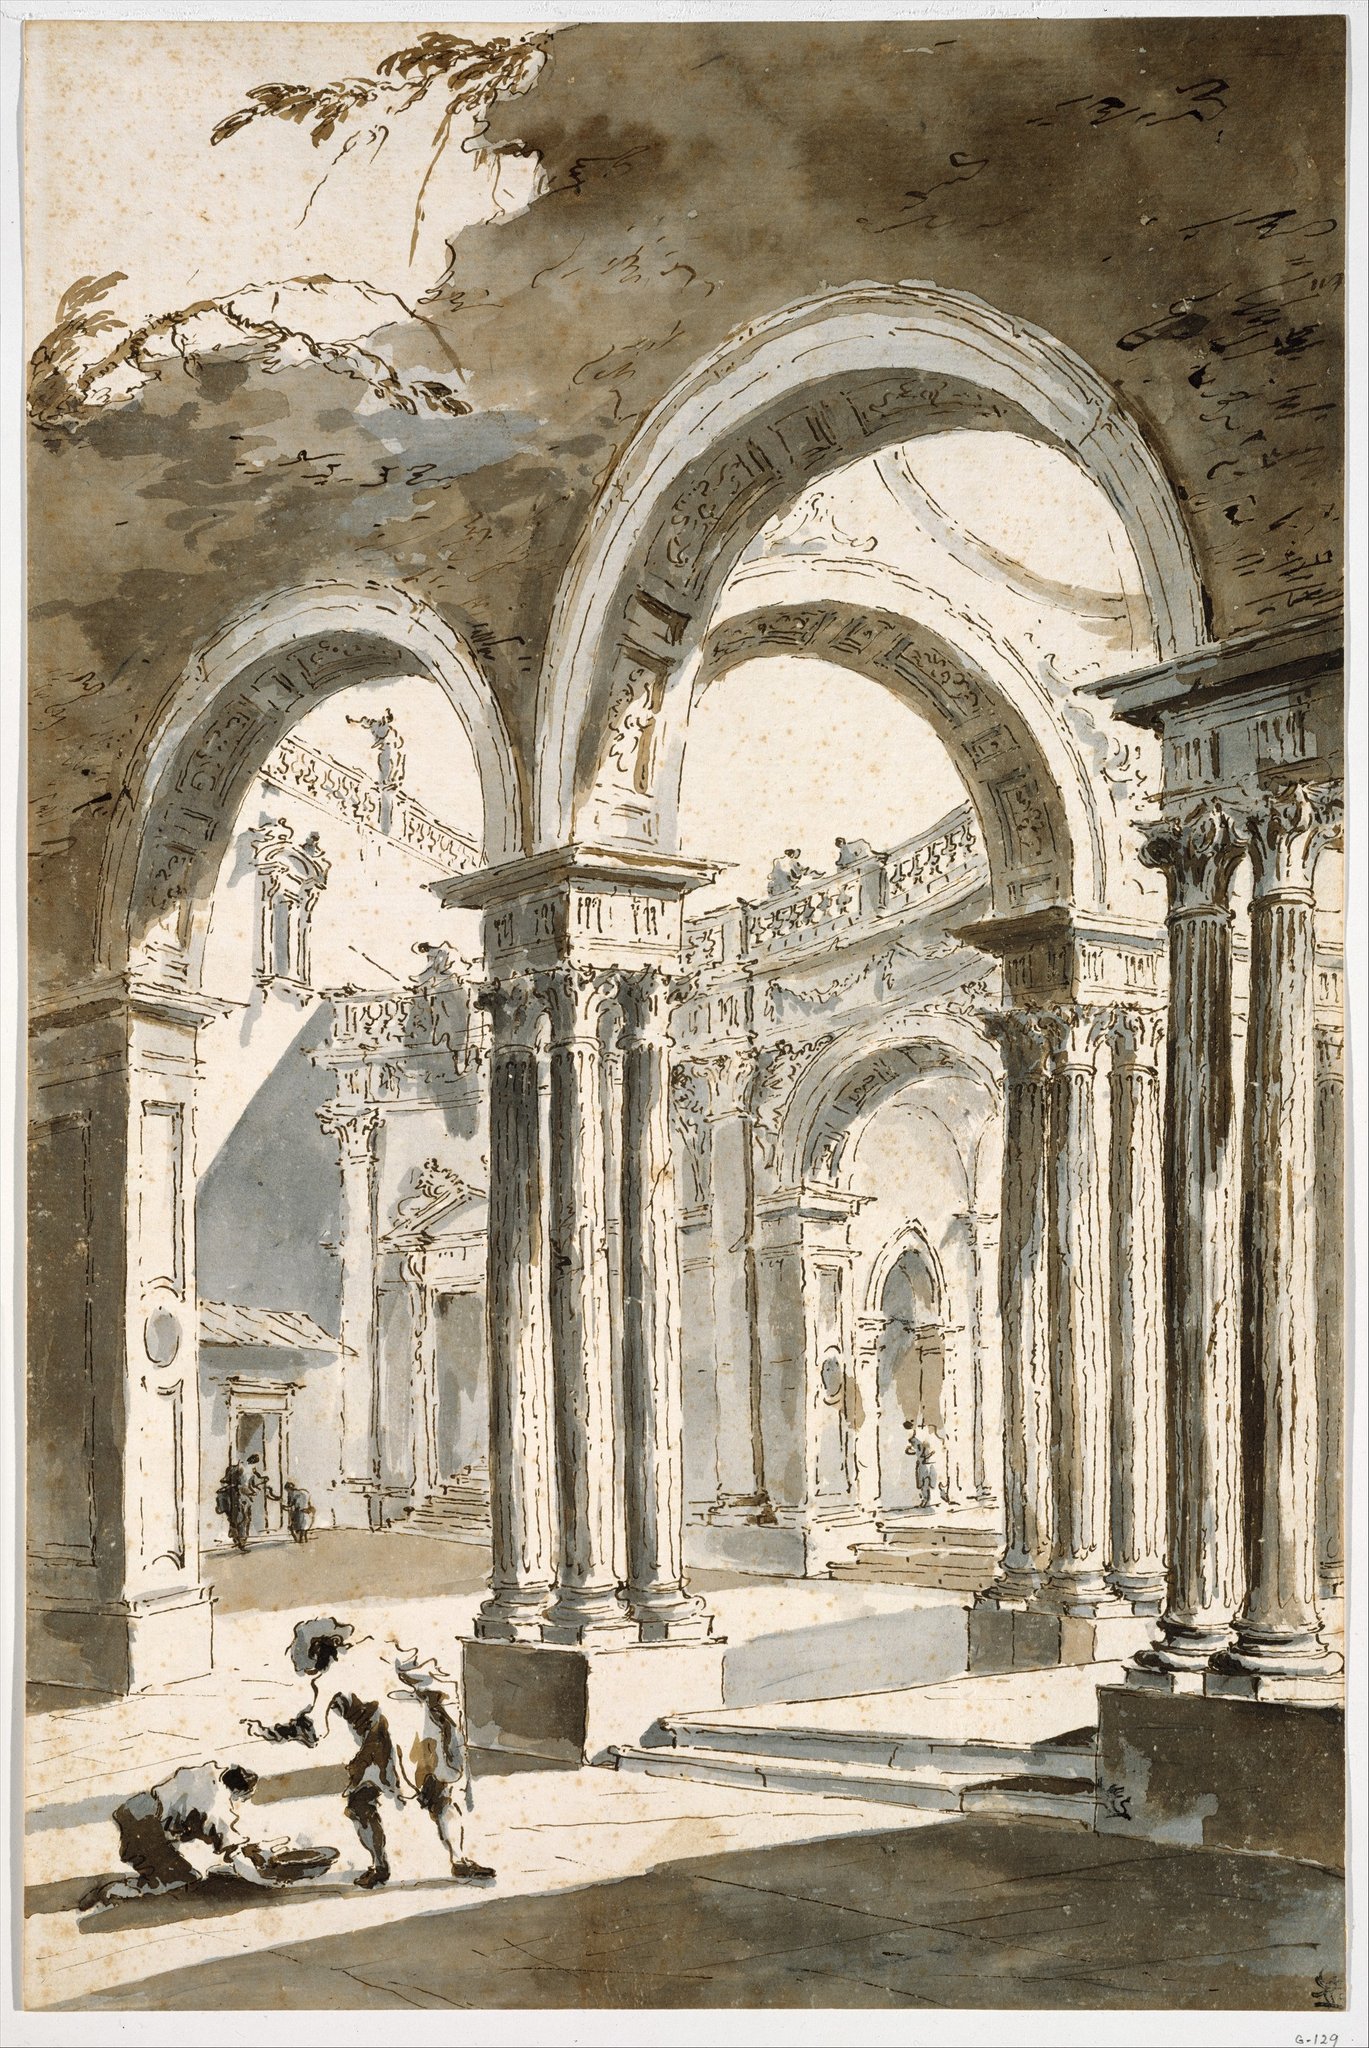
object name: drawing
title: A Colonnade, Partly Ruined, with Figures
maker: francesco guardi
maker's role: artist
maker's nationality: italian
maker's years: 1712-1793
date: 1780-1790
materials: ink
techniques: pen, wash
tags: architecture,ruins